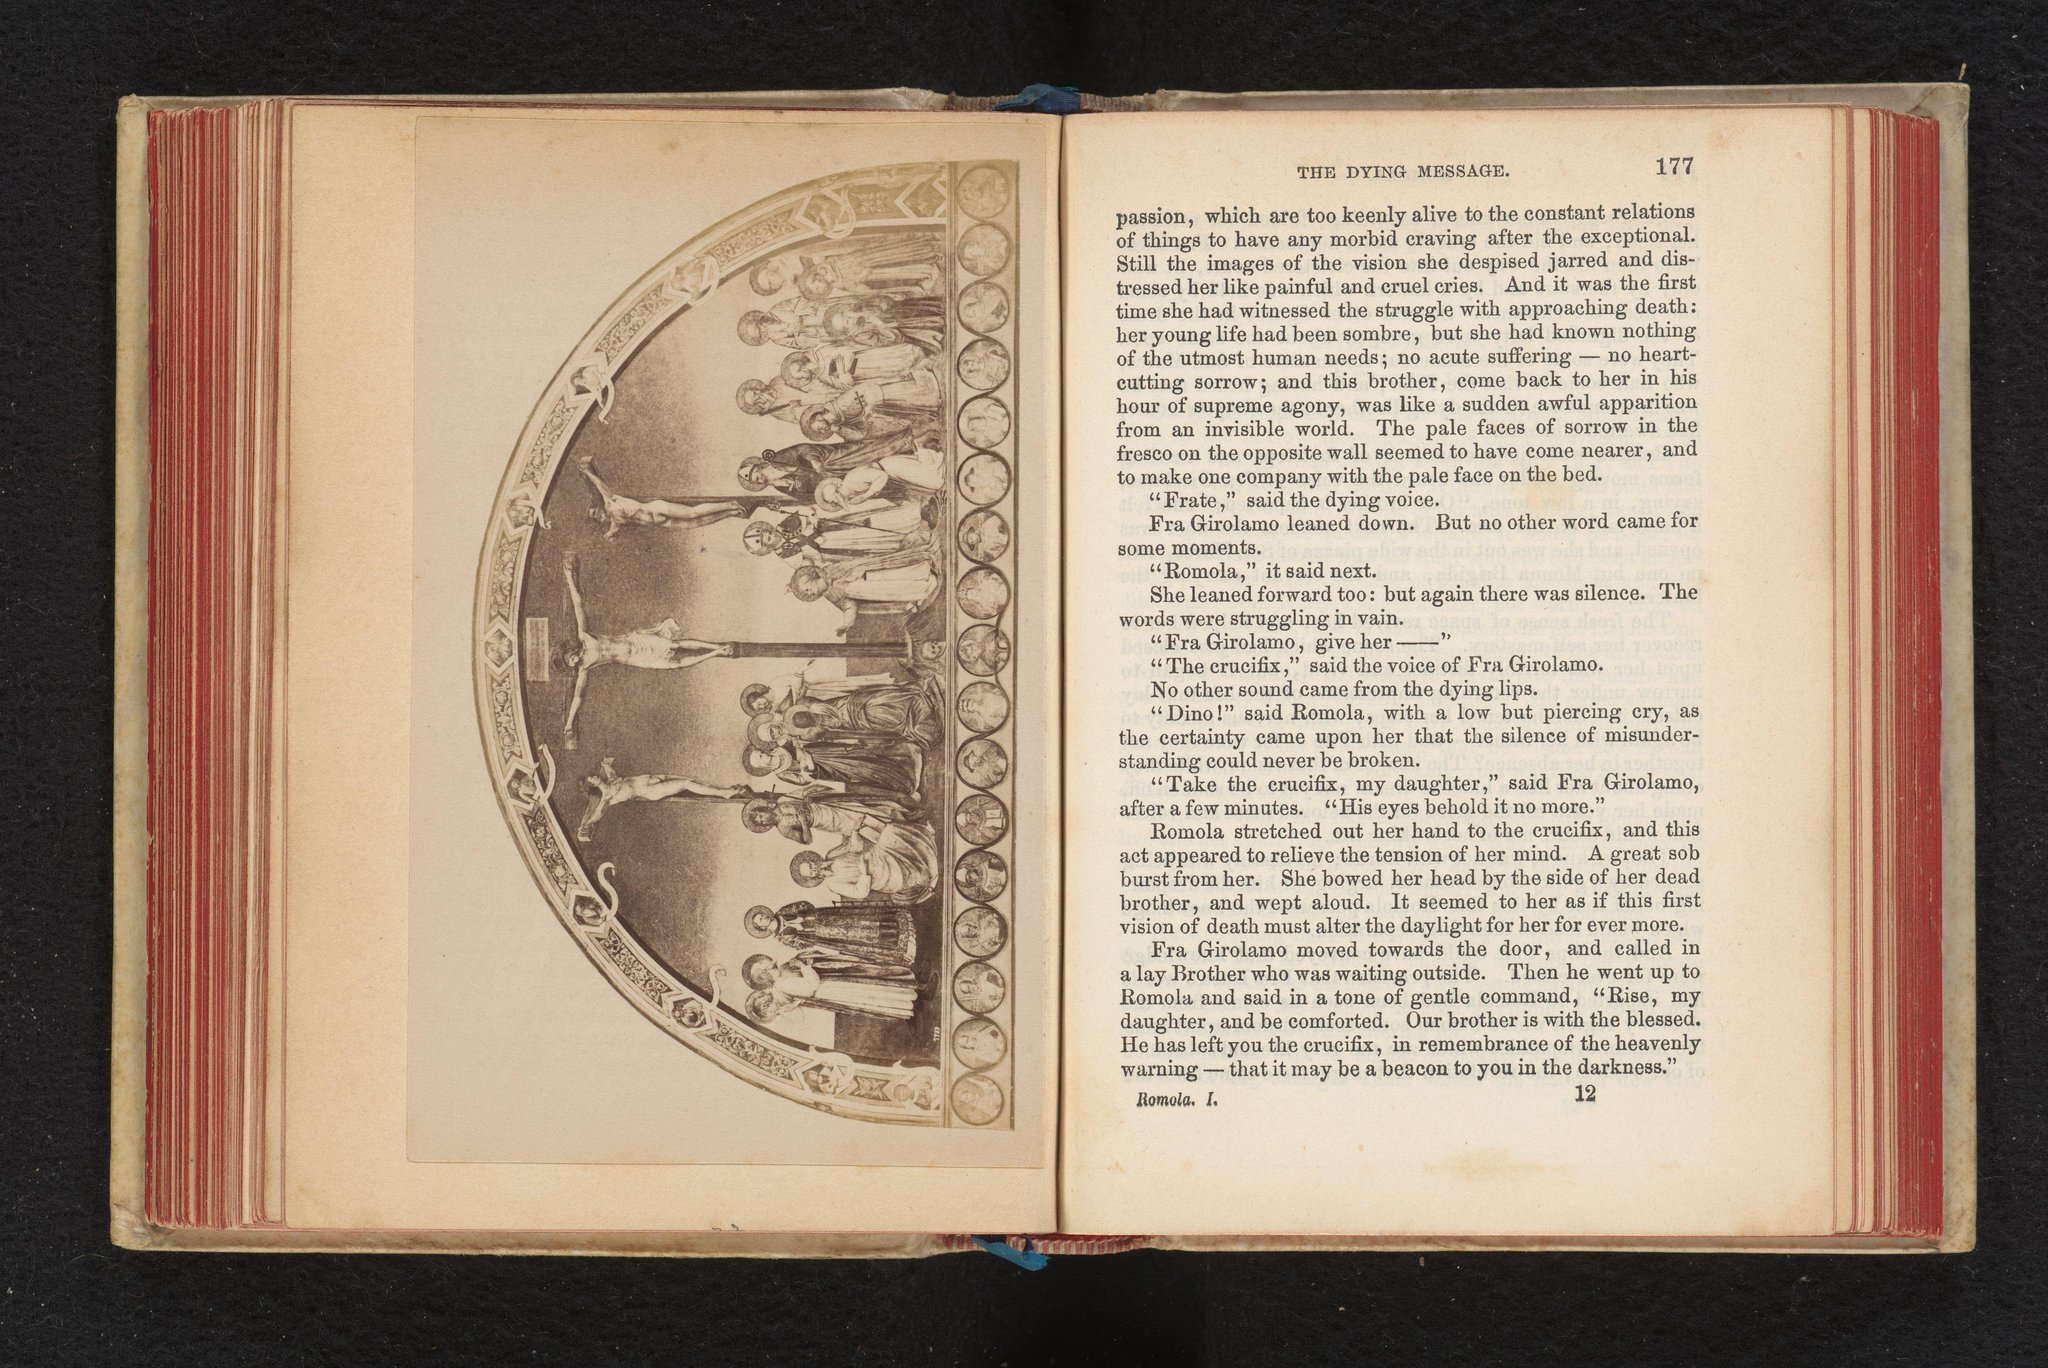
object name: page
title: Fotoreproductie van een fresco van de Kruisiging door Beato Angelico in de San Marco, Florence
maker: giacomo brogi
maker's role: fotograaf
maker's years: 1822-1881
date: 1858-1863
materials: paper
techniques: albumen print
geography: florence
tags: the crucifixion of christ: christ's death on the cross; golgotha (matthew 27:45-58; mark 15:33-45; luke 23:44-52; john 19:25-38)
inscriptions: name: ‘Brogi’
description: Foto op ongenummerde pagina tegenover pagina 177.